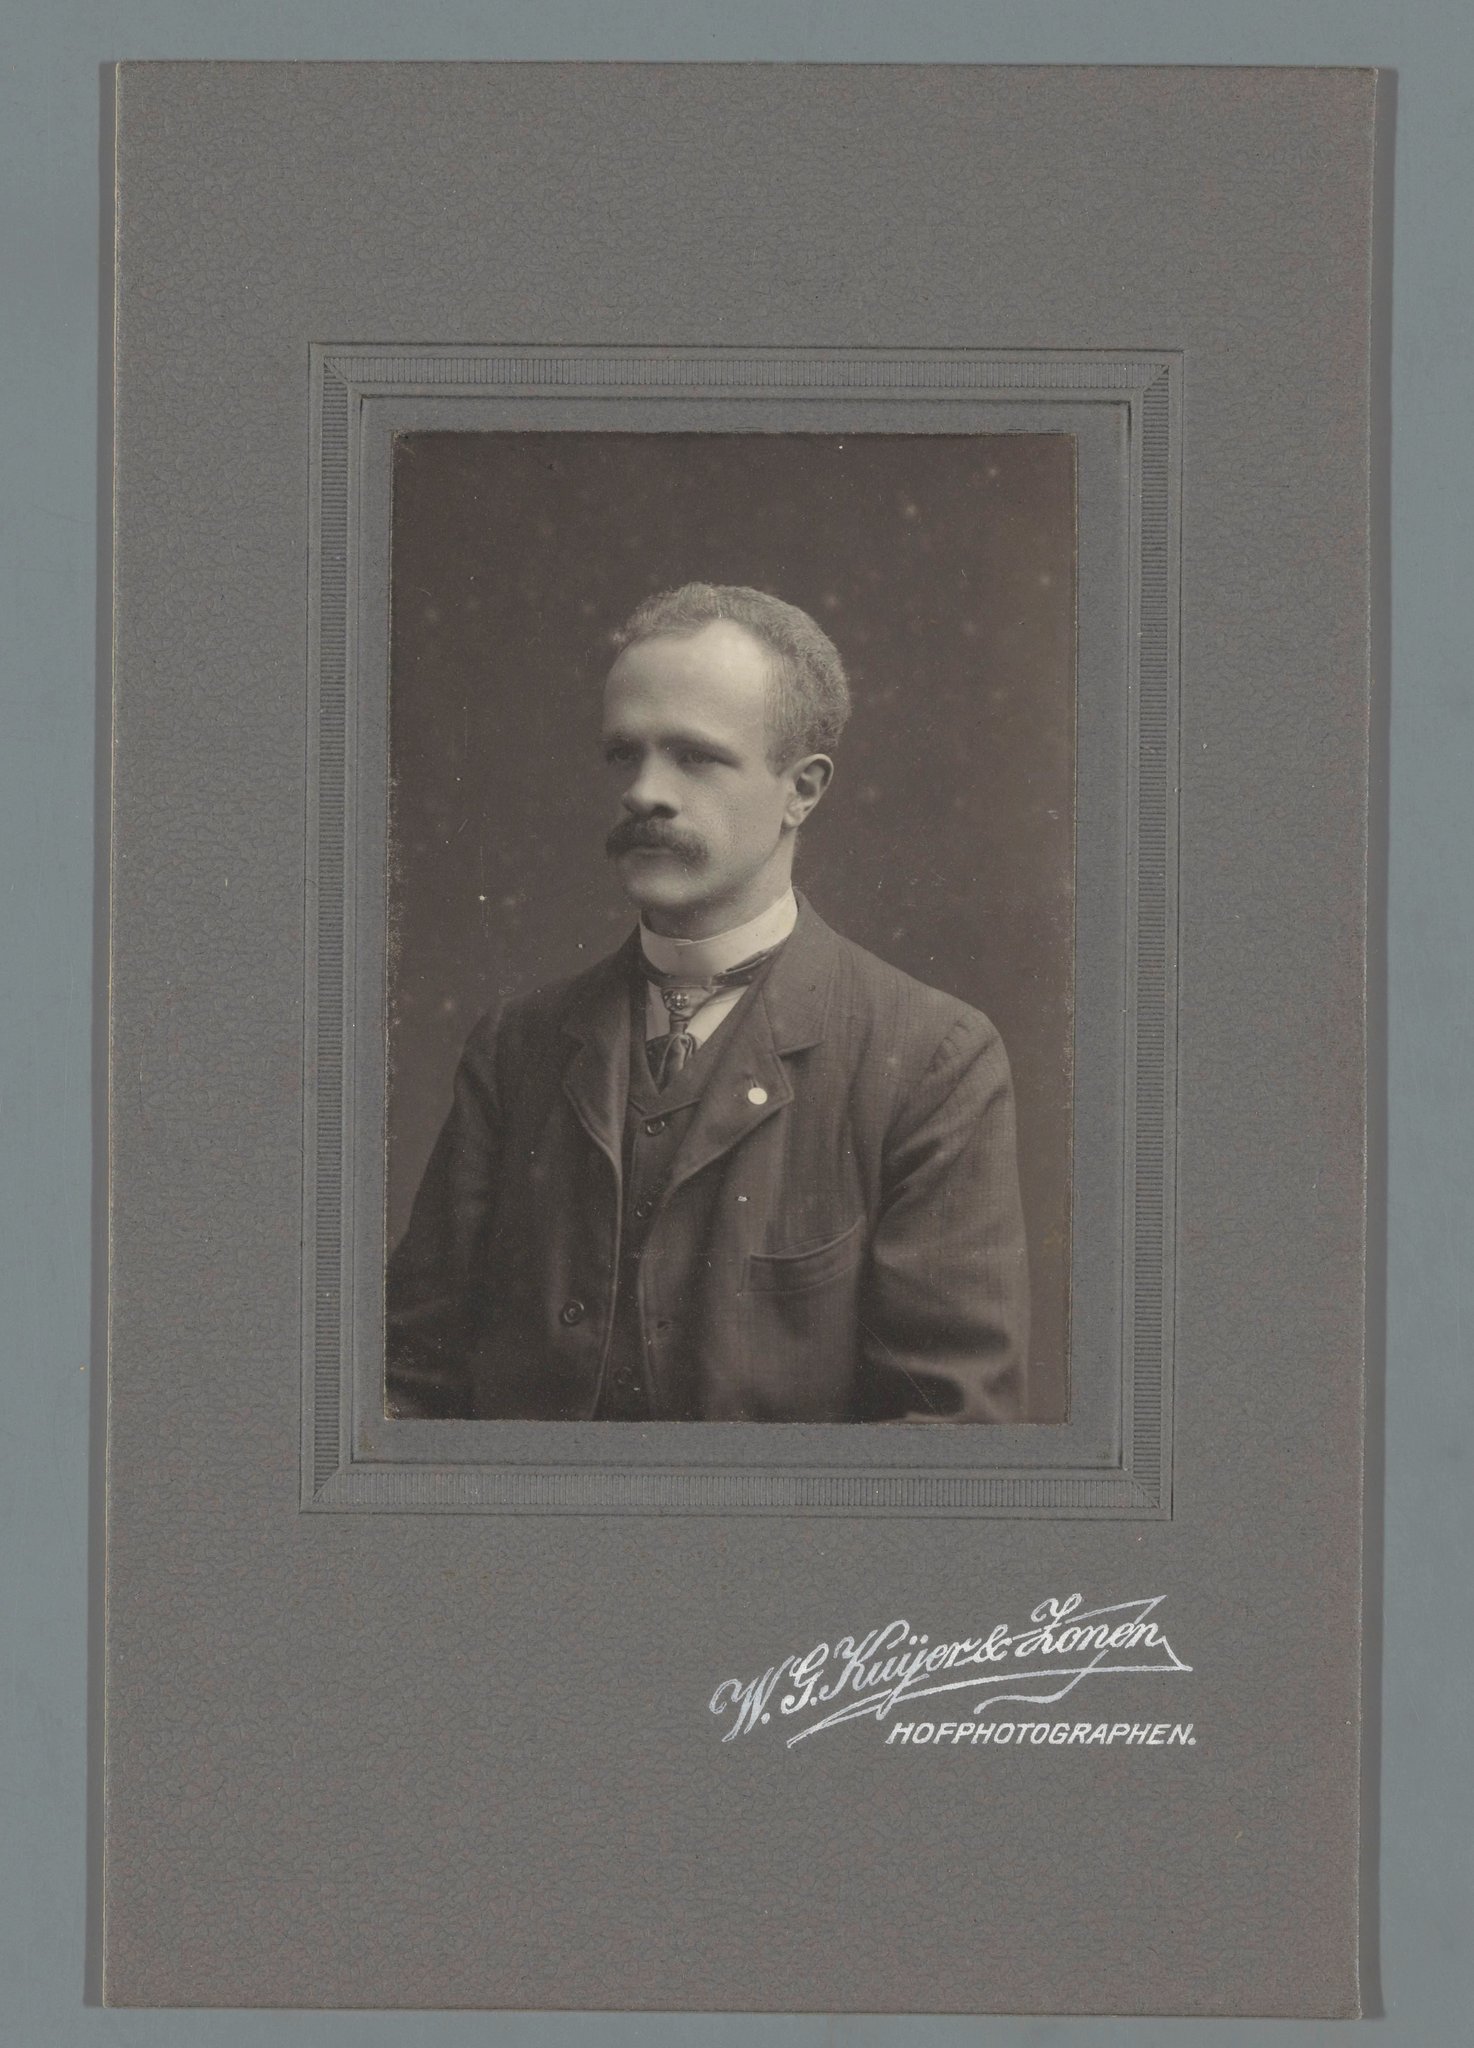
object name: cabinet photograph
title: Portret van een onbekende man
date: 1885-1906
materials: cardboard, photographic support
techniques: gelatin silver print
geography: amsterdam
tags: moustache, adult man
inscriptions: name: ‘W.G. Kuijer & Zonen Hofphotographen.’